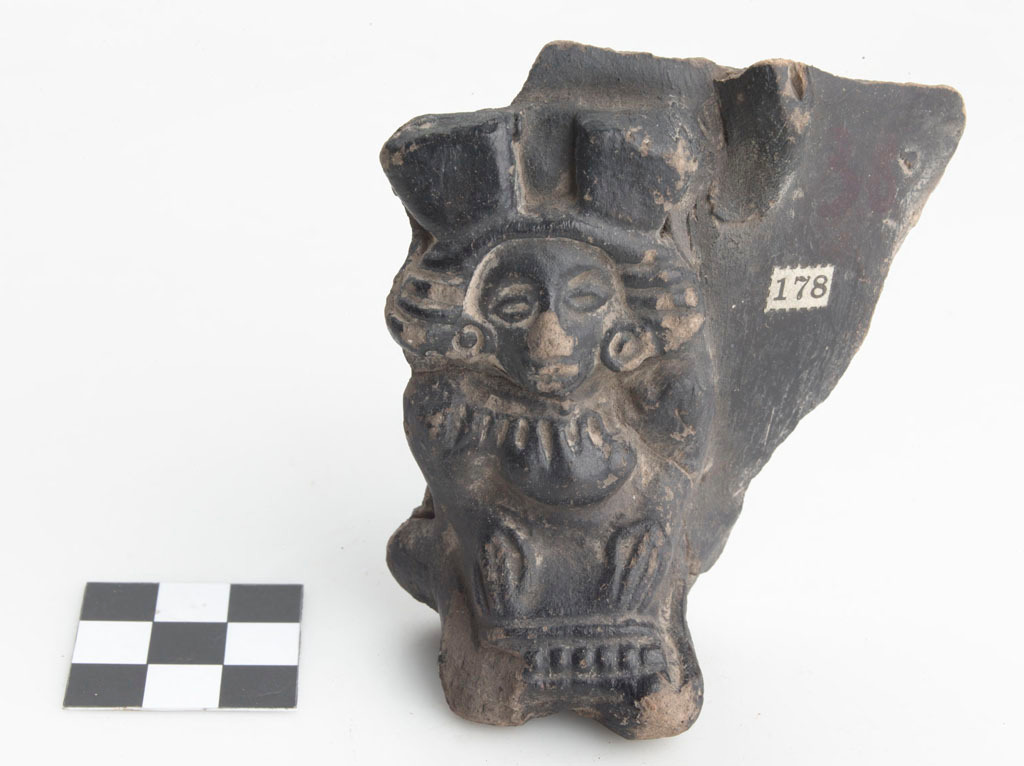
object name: figure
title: Human Figure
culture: maya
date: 100 BCE-200 CE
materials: clay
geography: mexico